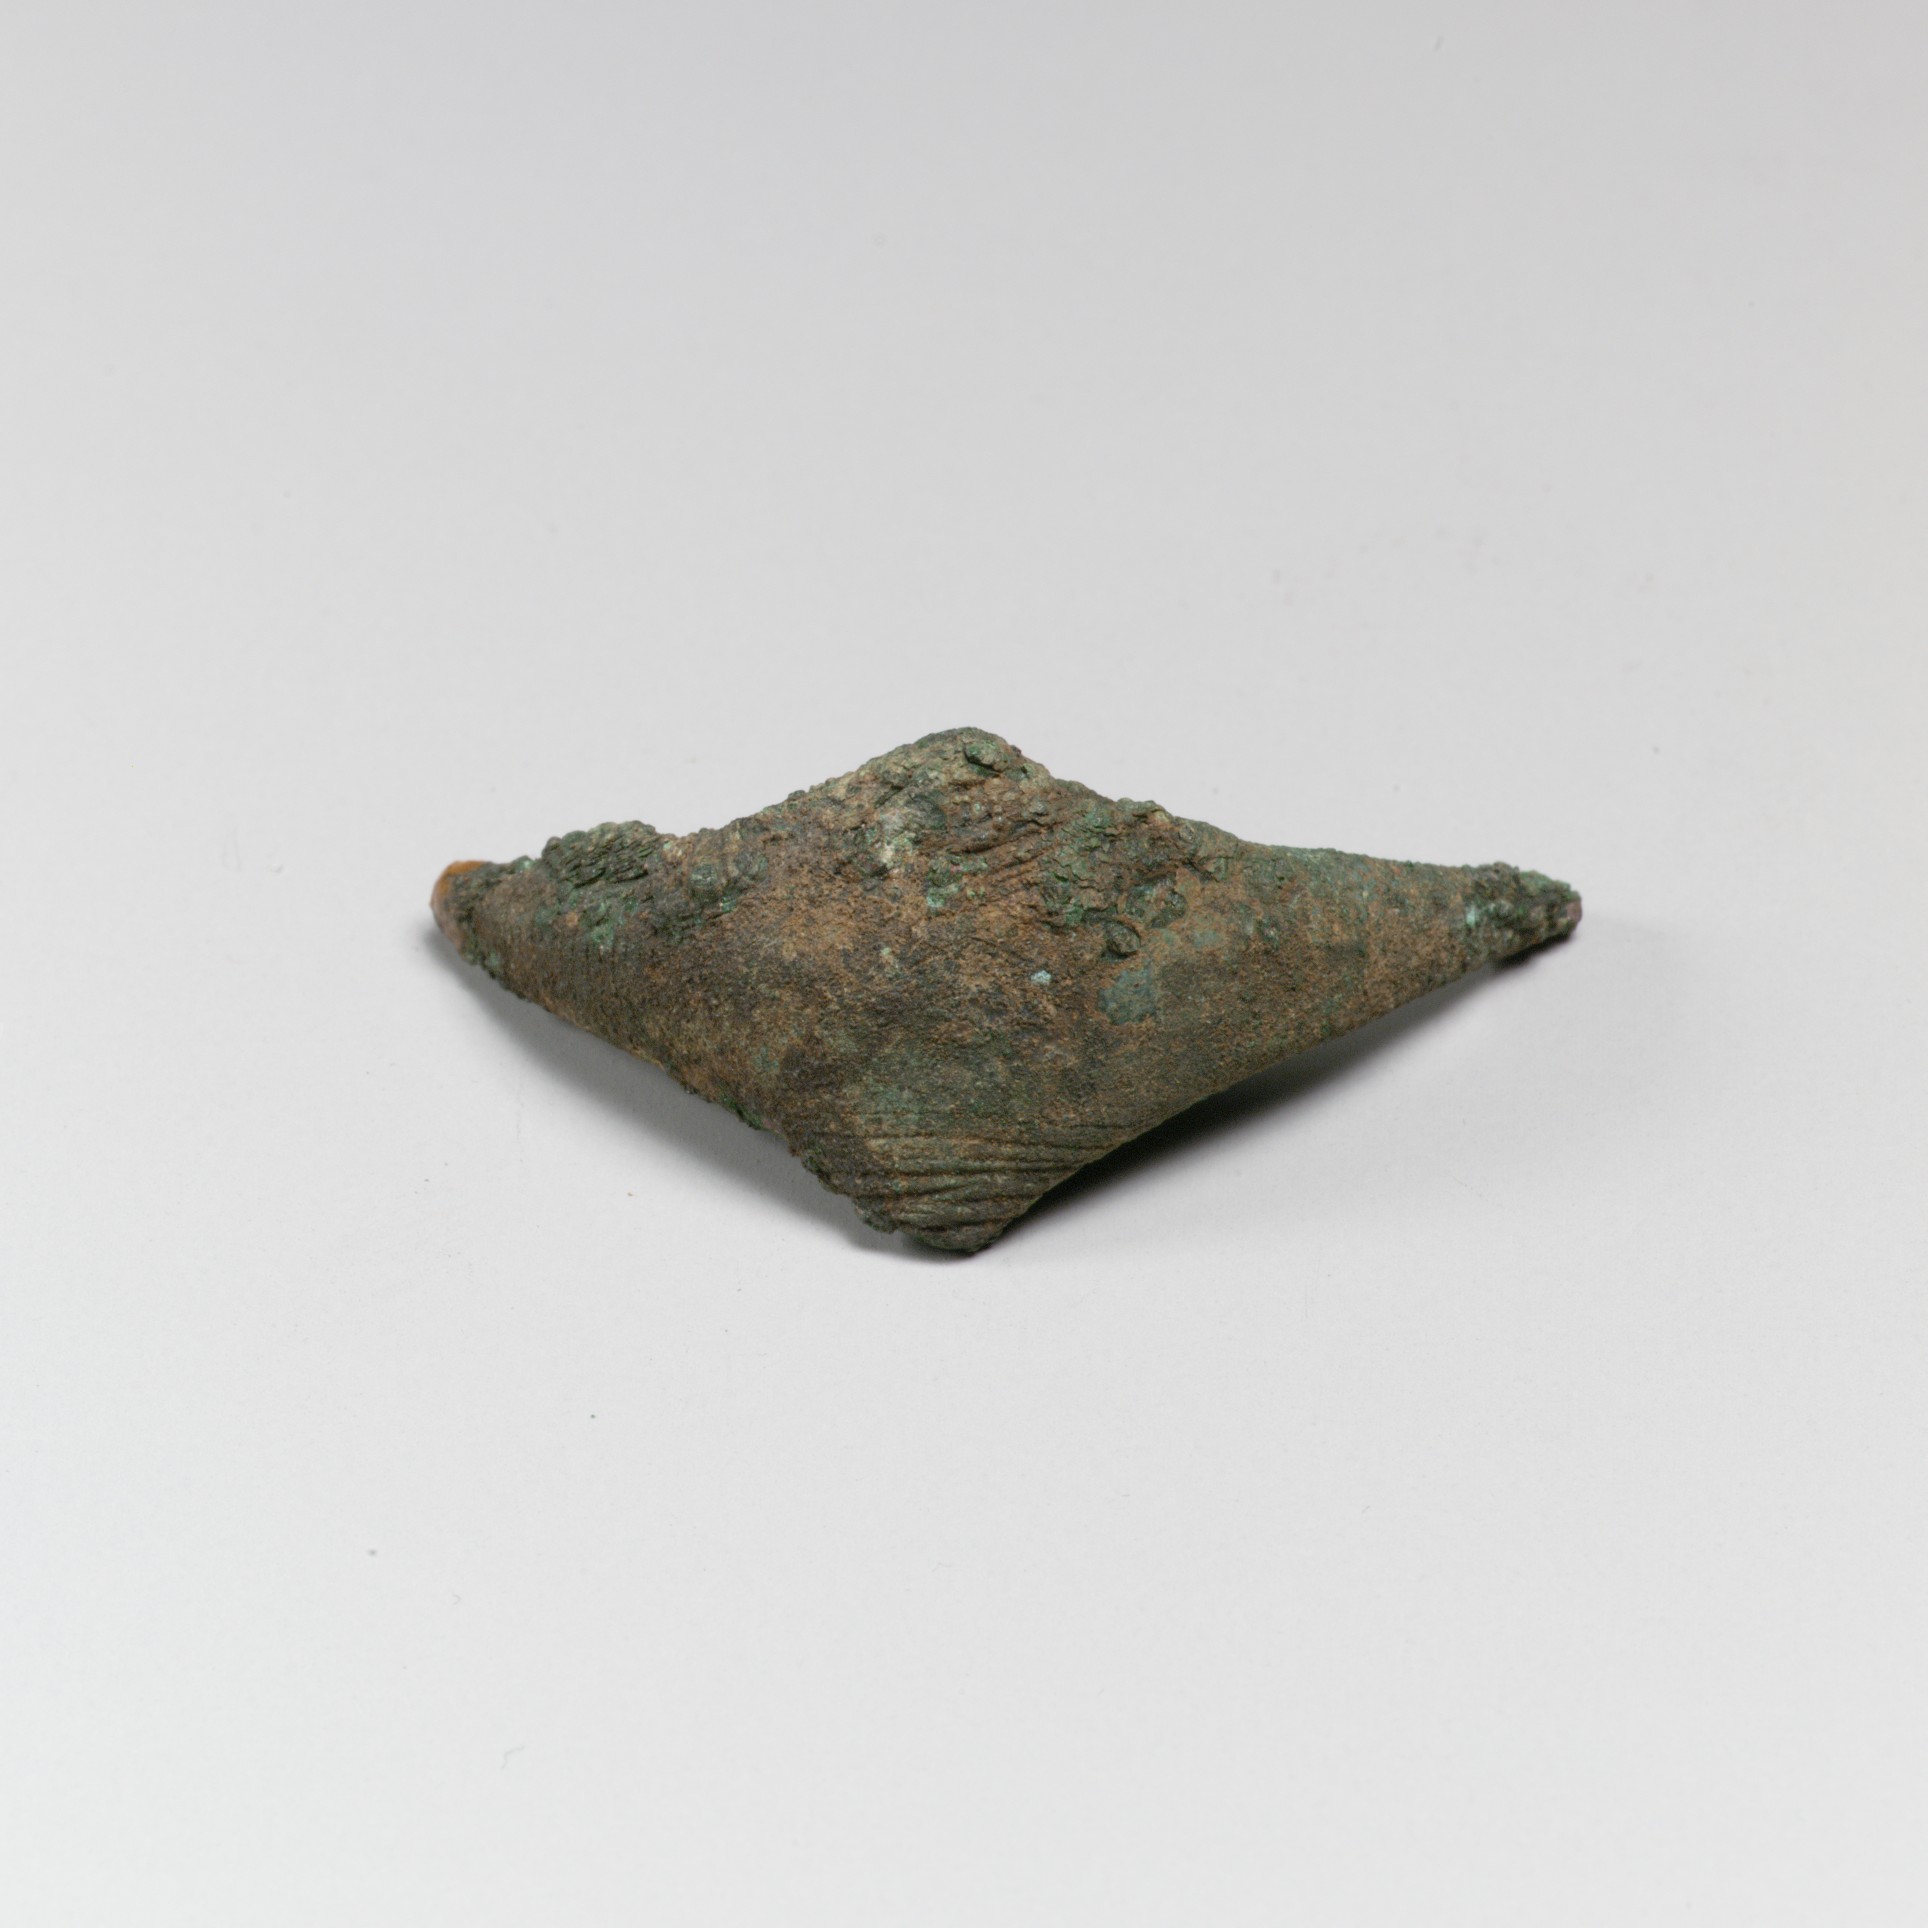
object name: fibula, boat shaped type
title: Fibula, boat-shaped type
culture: italic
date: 900-701 BCE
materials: bronze